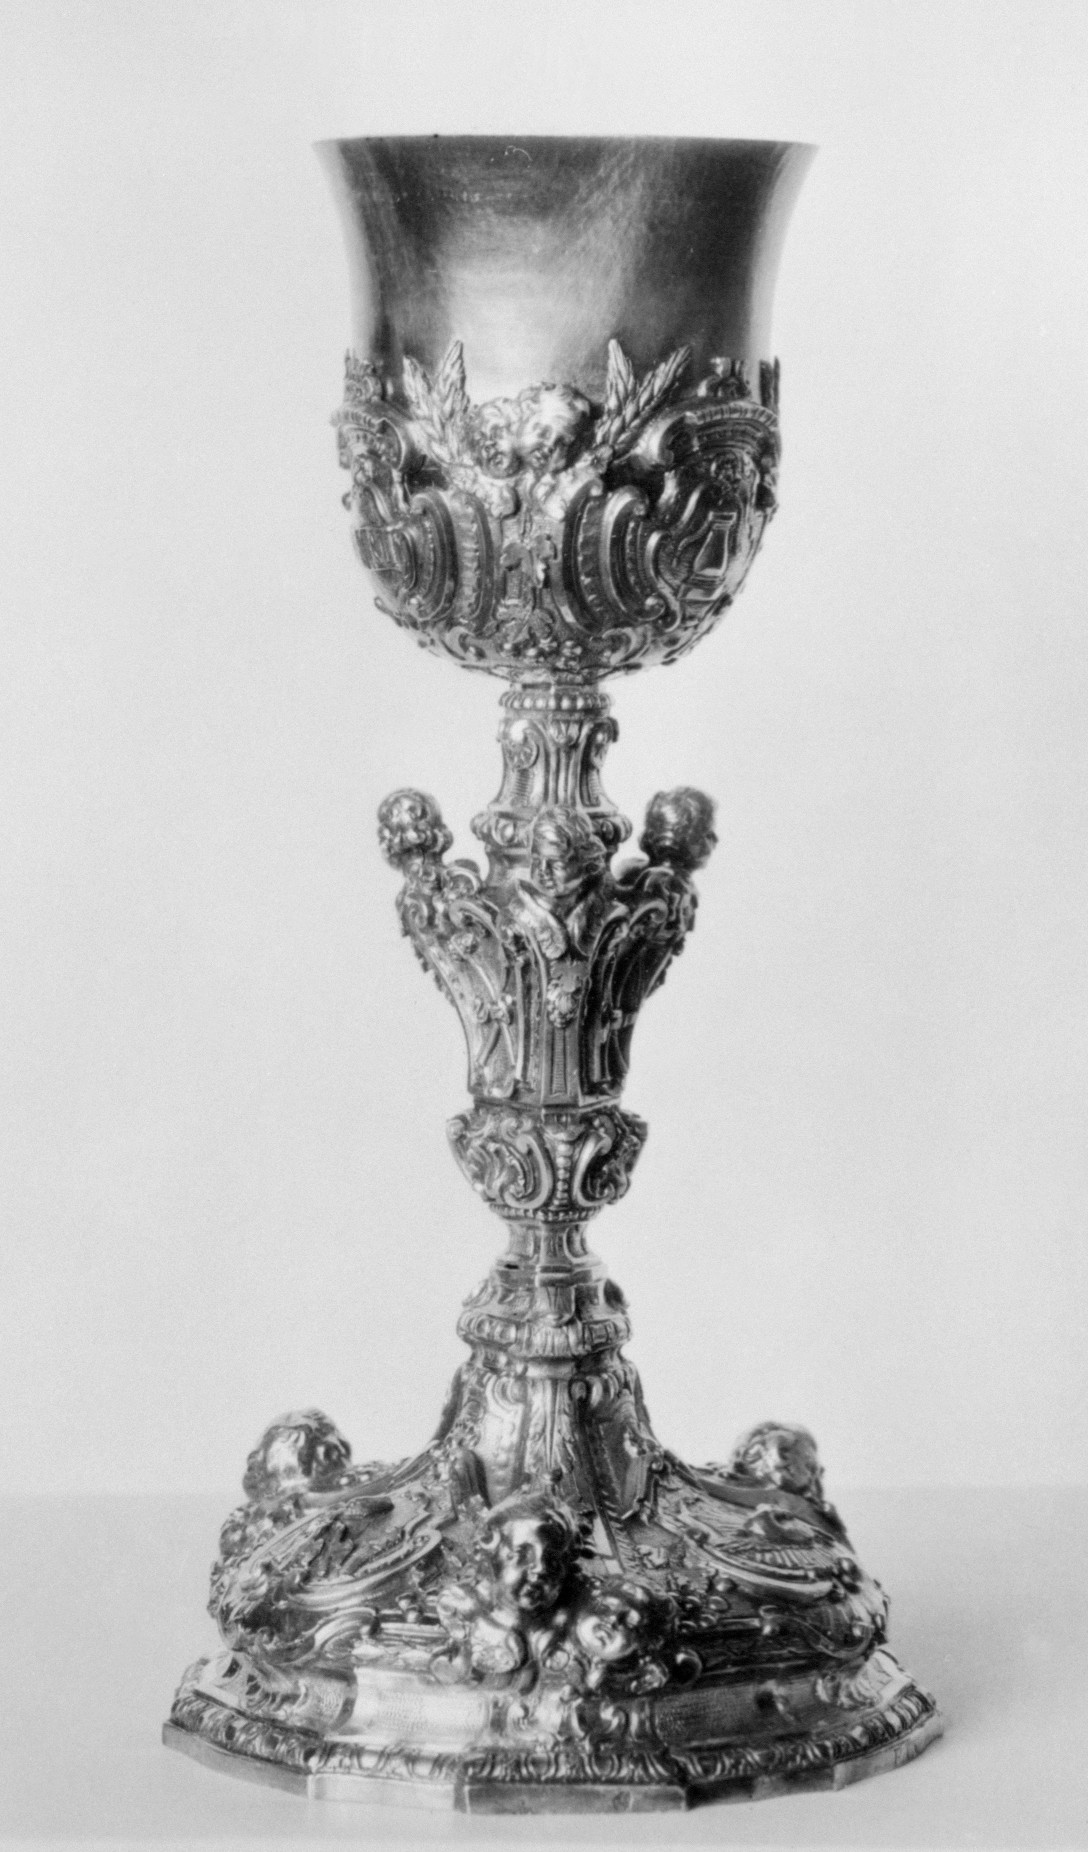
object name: chalice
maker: giovanni valadier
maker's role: maker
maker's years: 1732-1805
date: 1767-1800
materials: gilt, silver